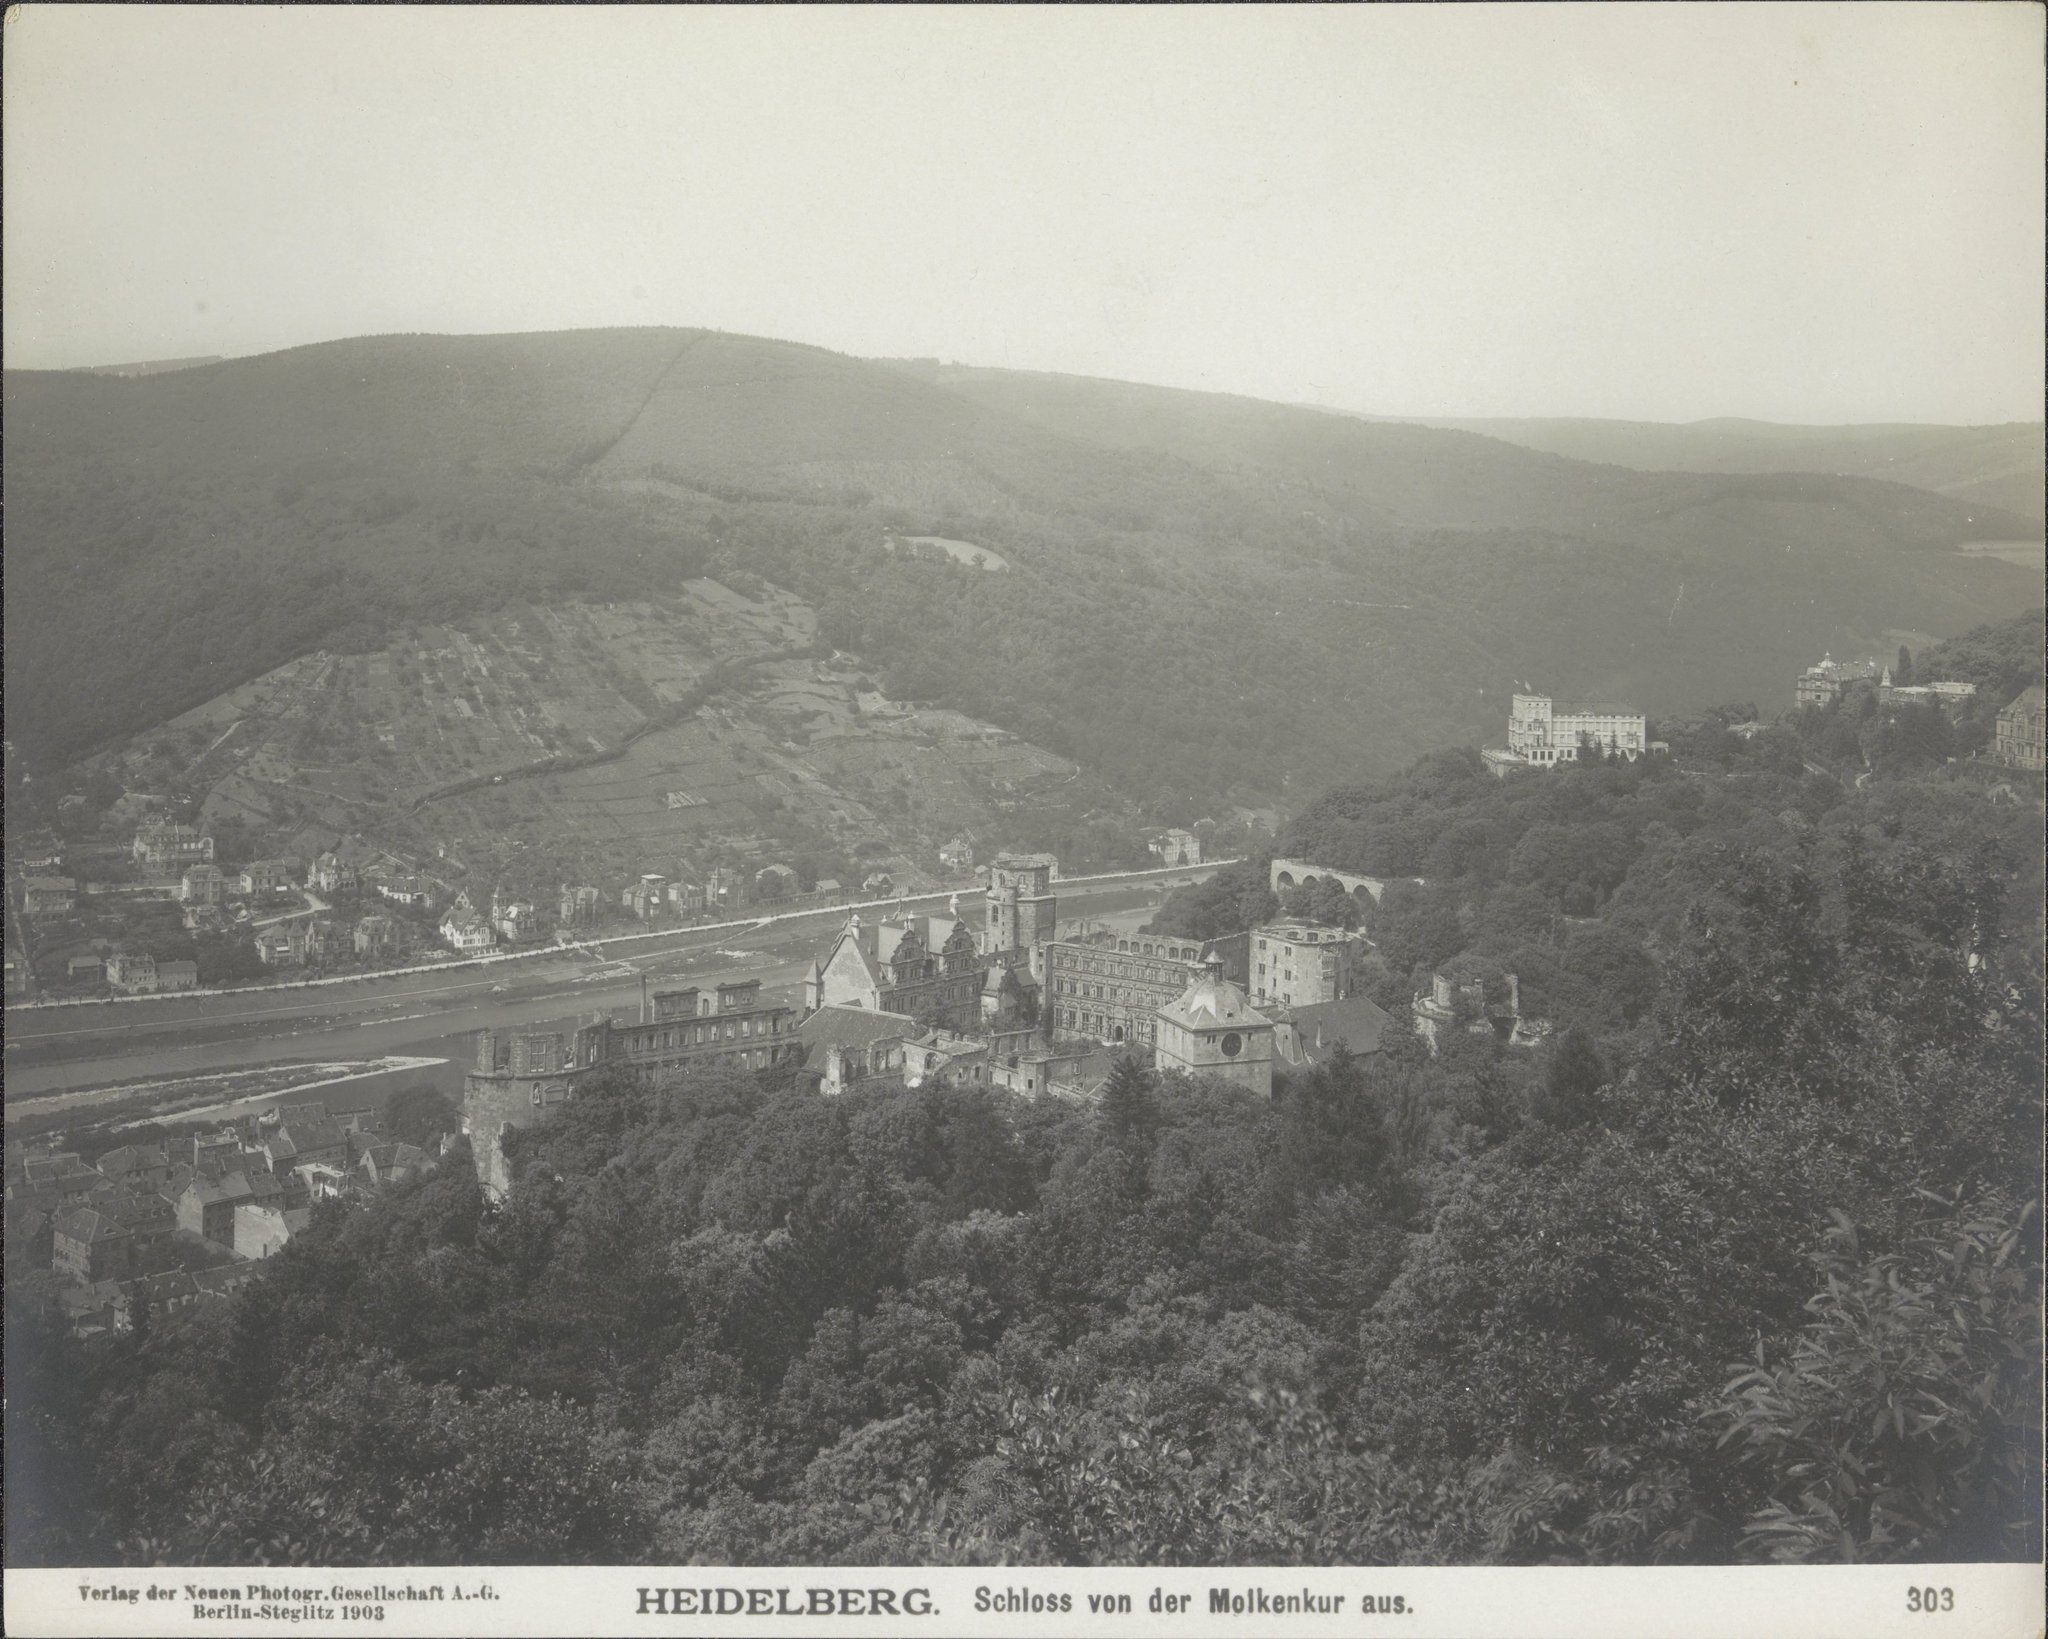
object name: photograph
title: Schloss Heidelberg gezien vanaf de Molkenkur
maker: Anonymous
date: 1903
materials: photographic support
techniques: gelatin silver print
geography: heidelberg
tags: castle, prospect of city, town panorama, silhouette of city, ruin of a dwelling, house, castle, etc.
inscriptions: number: ‘303’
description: Onderdeel van Fotoalbum met opnames van Heidelberg en Schloss Heidelberg.